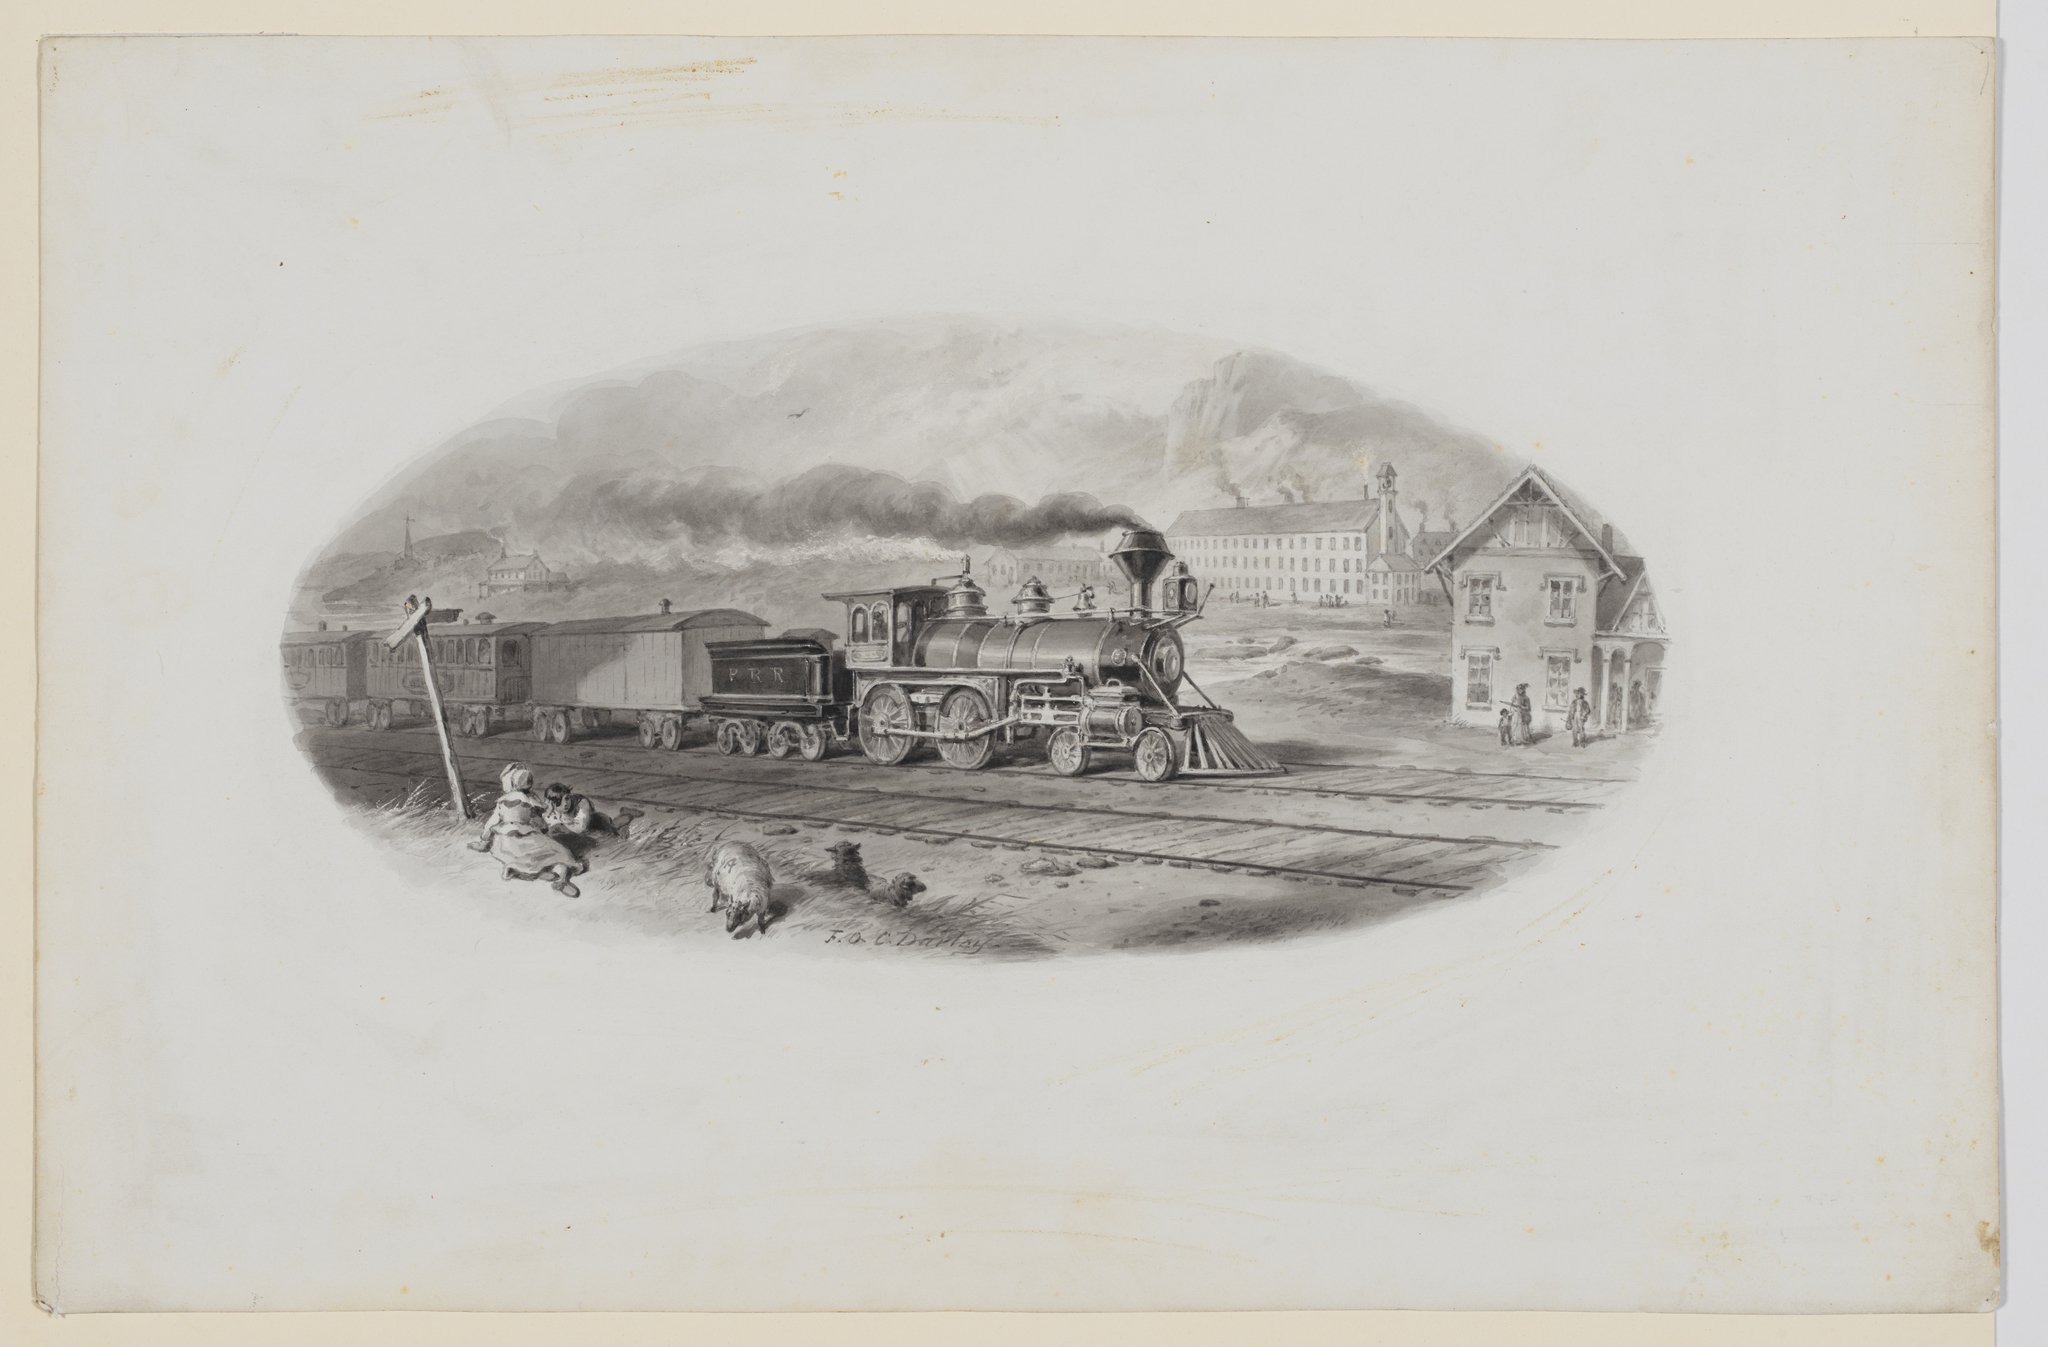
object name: drawing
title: A train in a landscape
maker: felix octavius carr darley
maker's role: artist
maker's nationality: american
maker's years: 1822-1888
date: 1845-1888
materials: chalk, ink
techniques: highlighting, wash